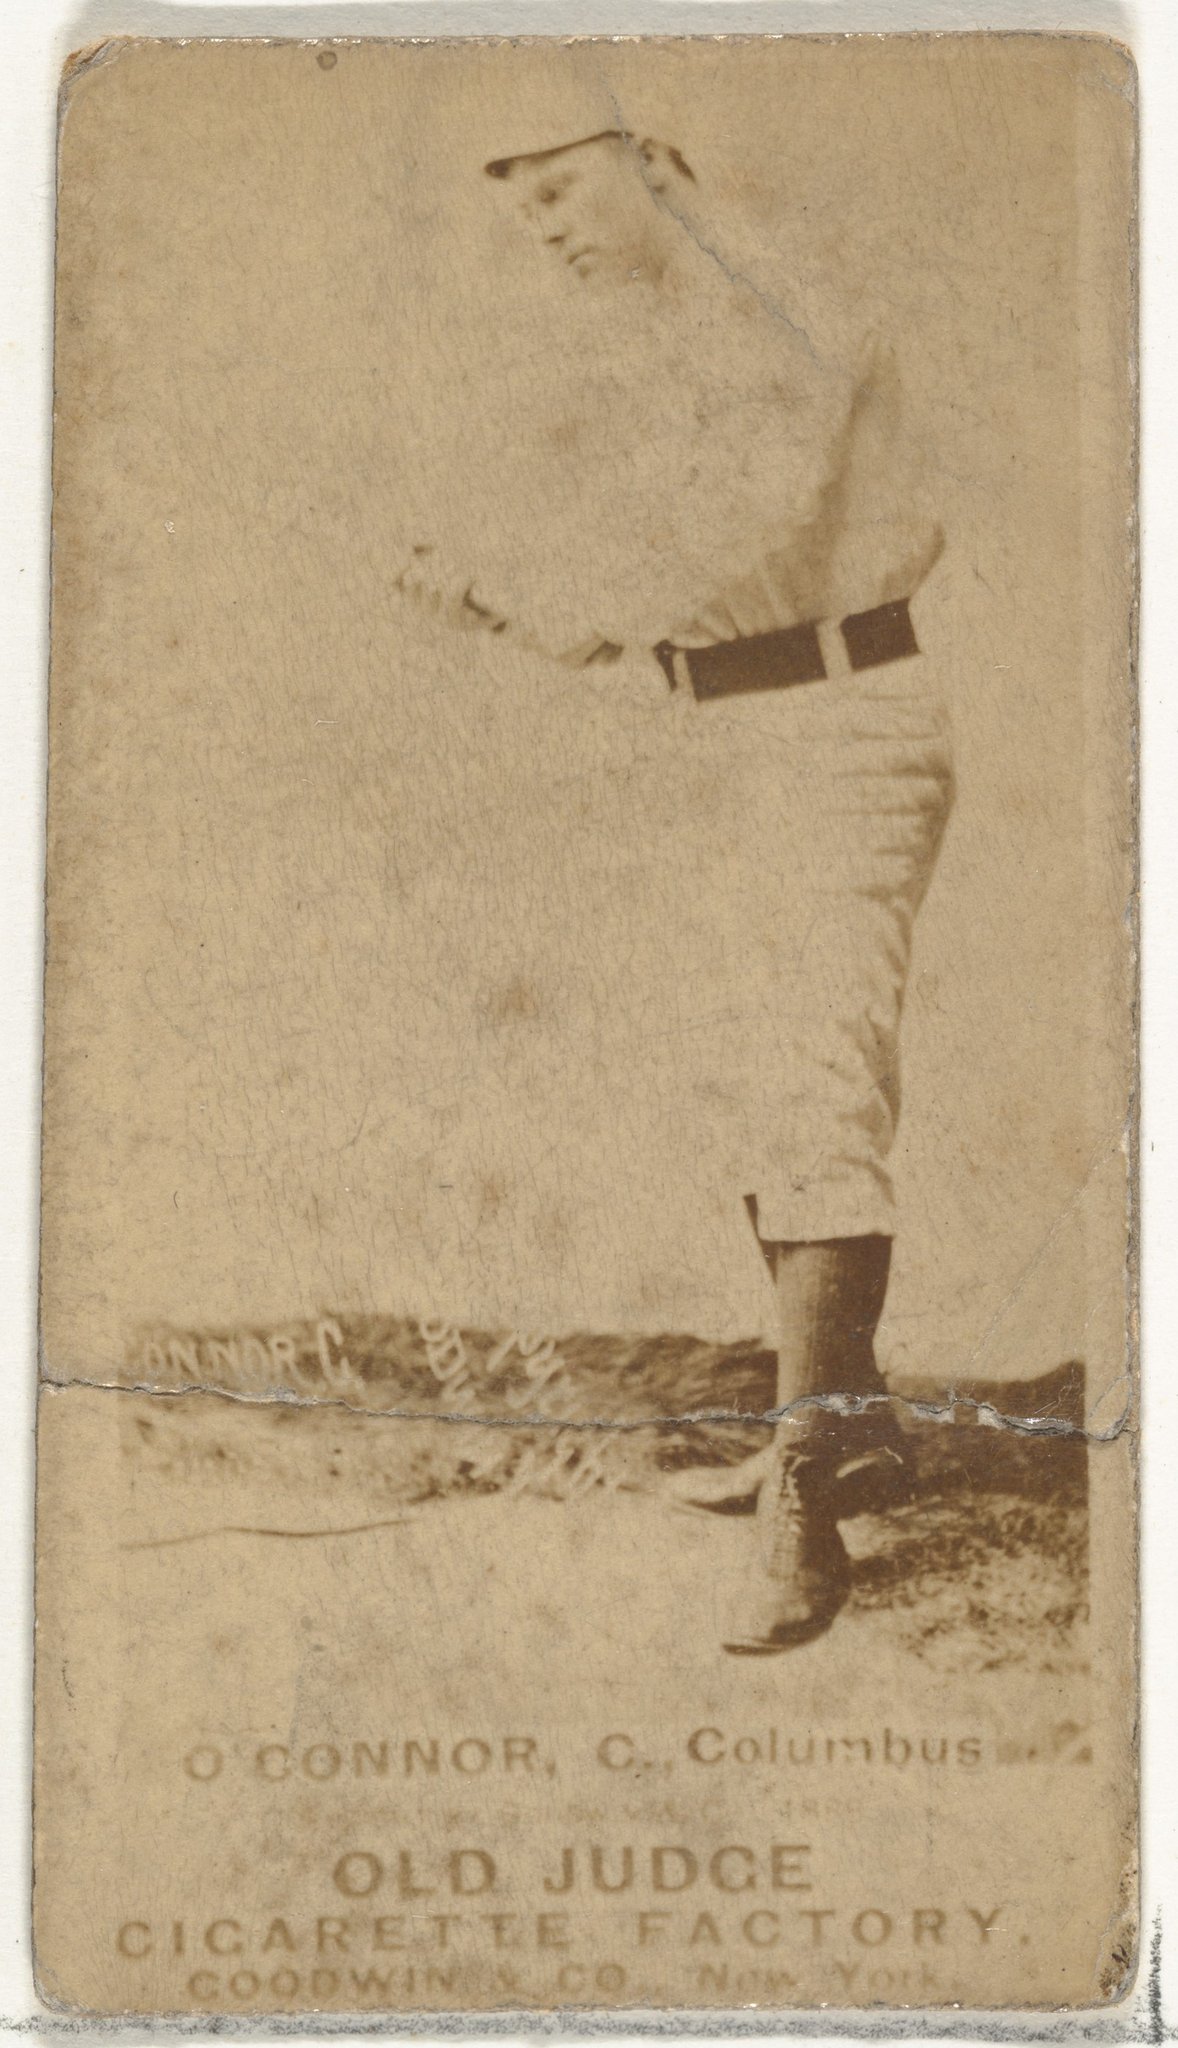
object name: baseball card, photograph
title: Jack "Peach Pie" O'Connor, Catcher, Cleveland, from the Old Judge series (N172) for Old Judge Cigarettes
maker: goodwin & company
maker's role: publisher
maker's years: 1850-1950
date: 1888-1889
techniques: albumen silver print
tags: men,portraits,baseball,athletes